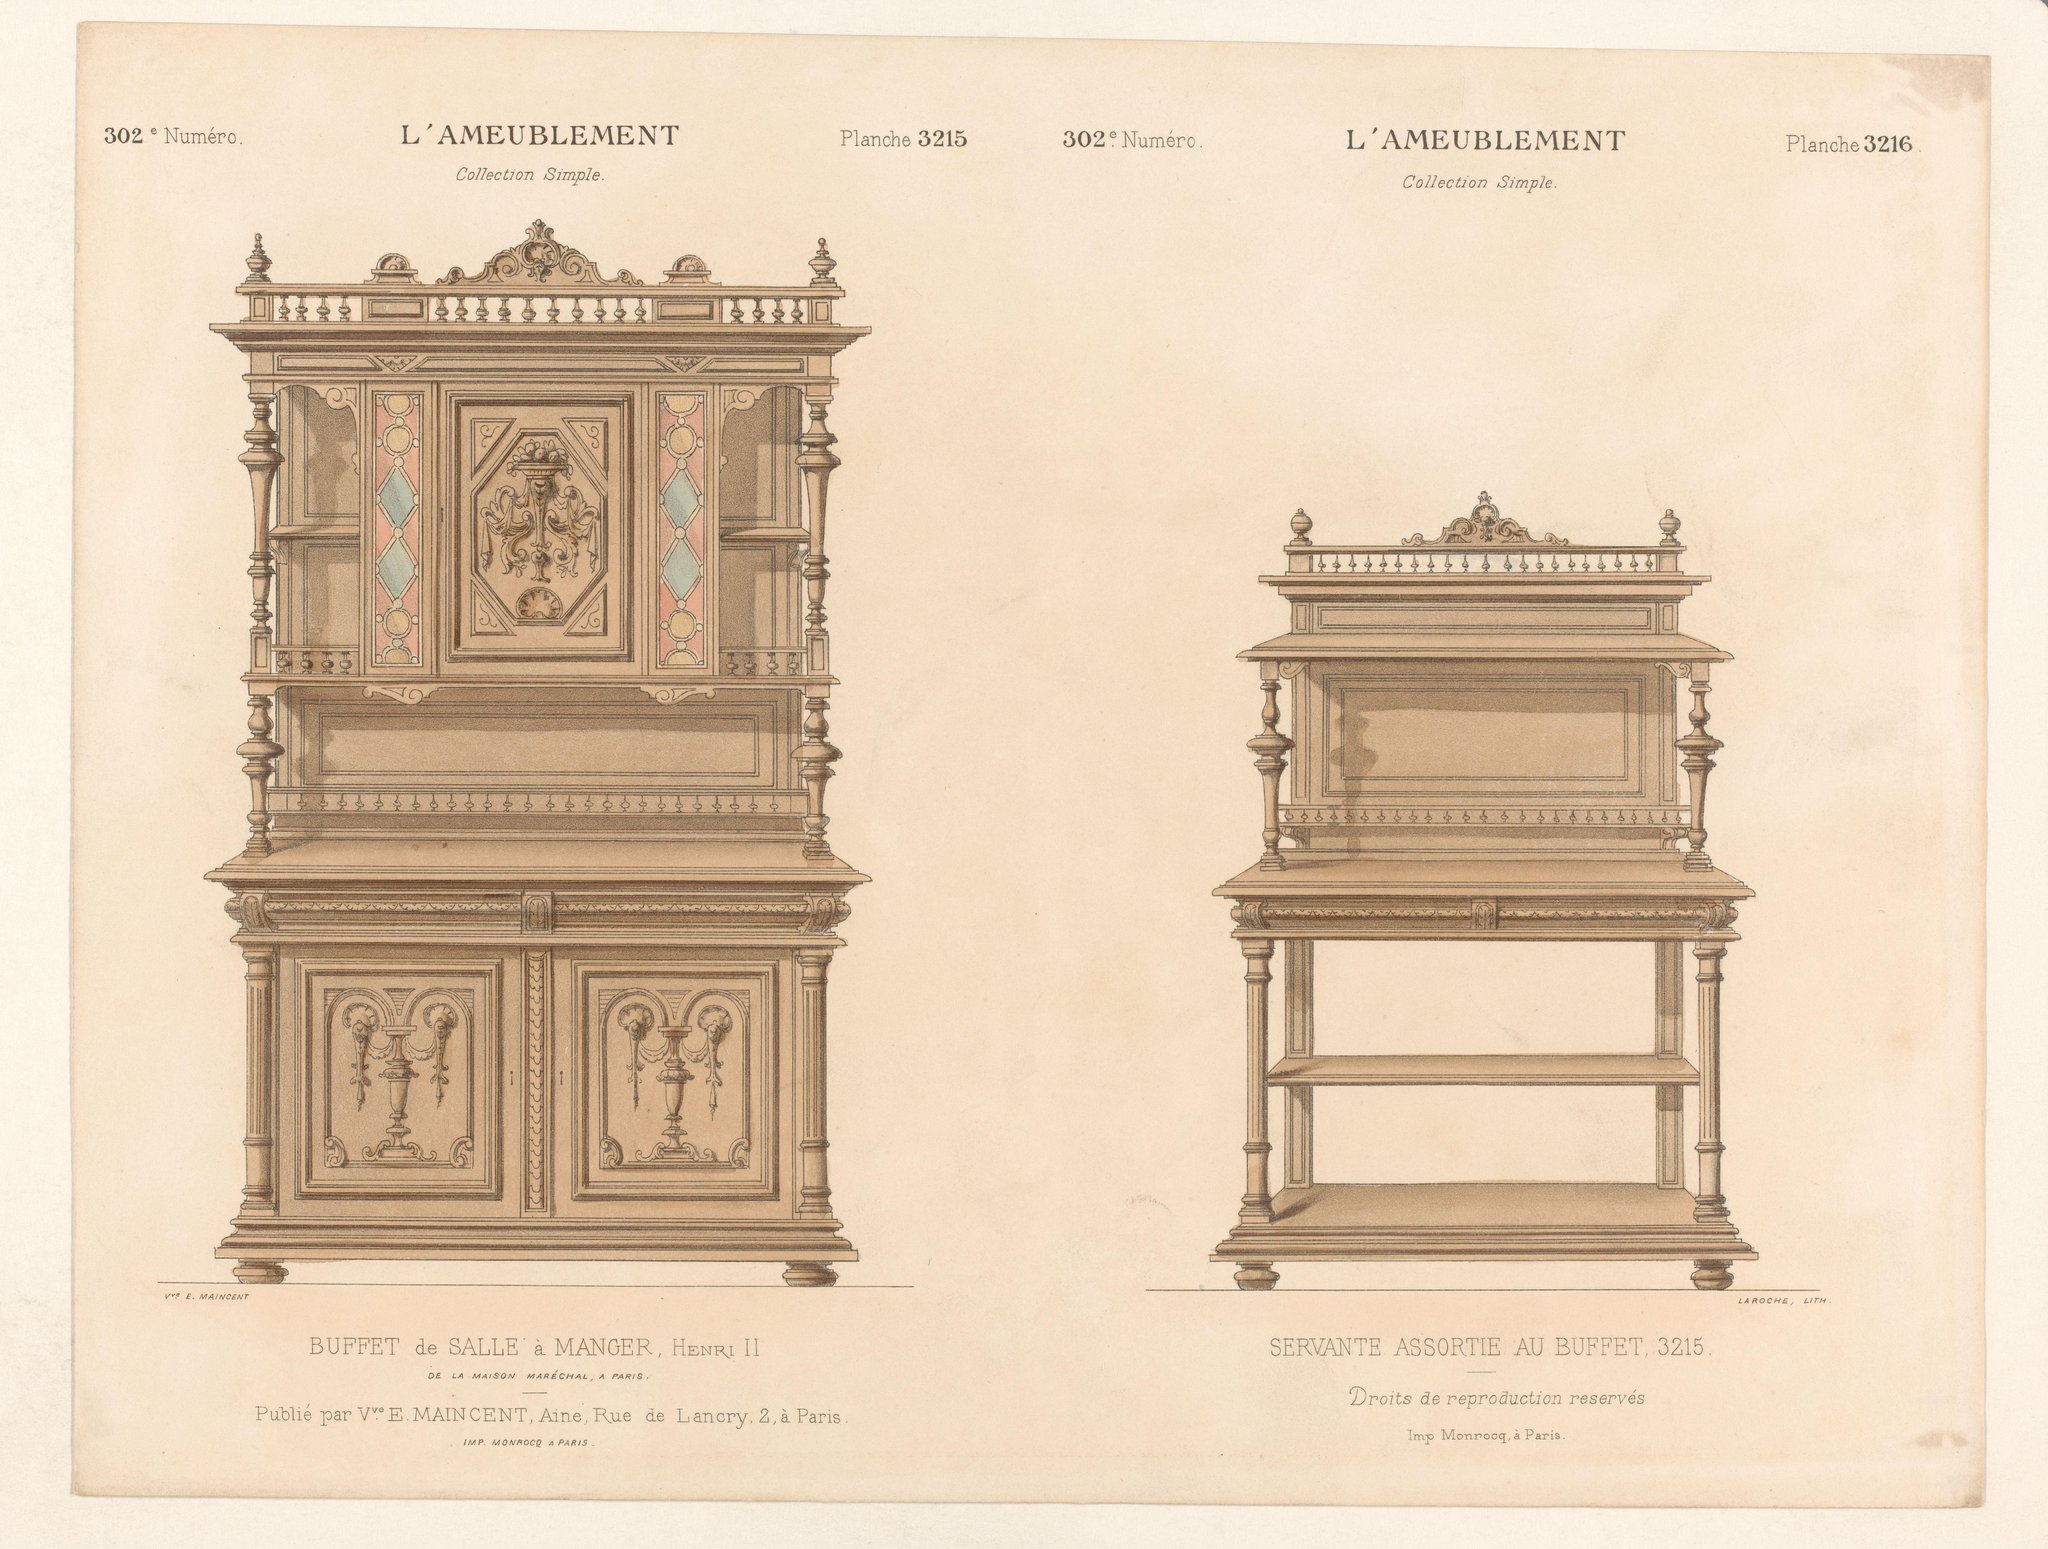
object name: print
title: Buffet de salle à manger, Henri II / Servante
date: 1895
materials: paper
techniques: hand coloring, lithograph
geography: paris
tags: furniture for storage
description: Een buffetkast en open kast in de Hendrik II-stijl. Prent uit 302e Livraison.